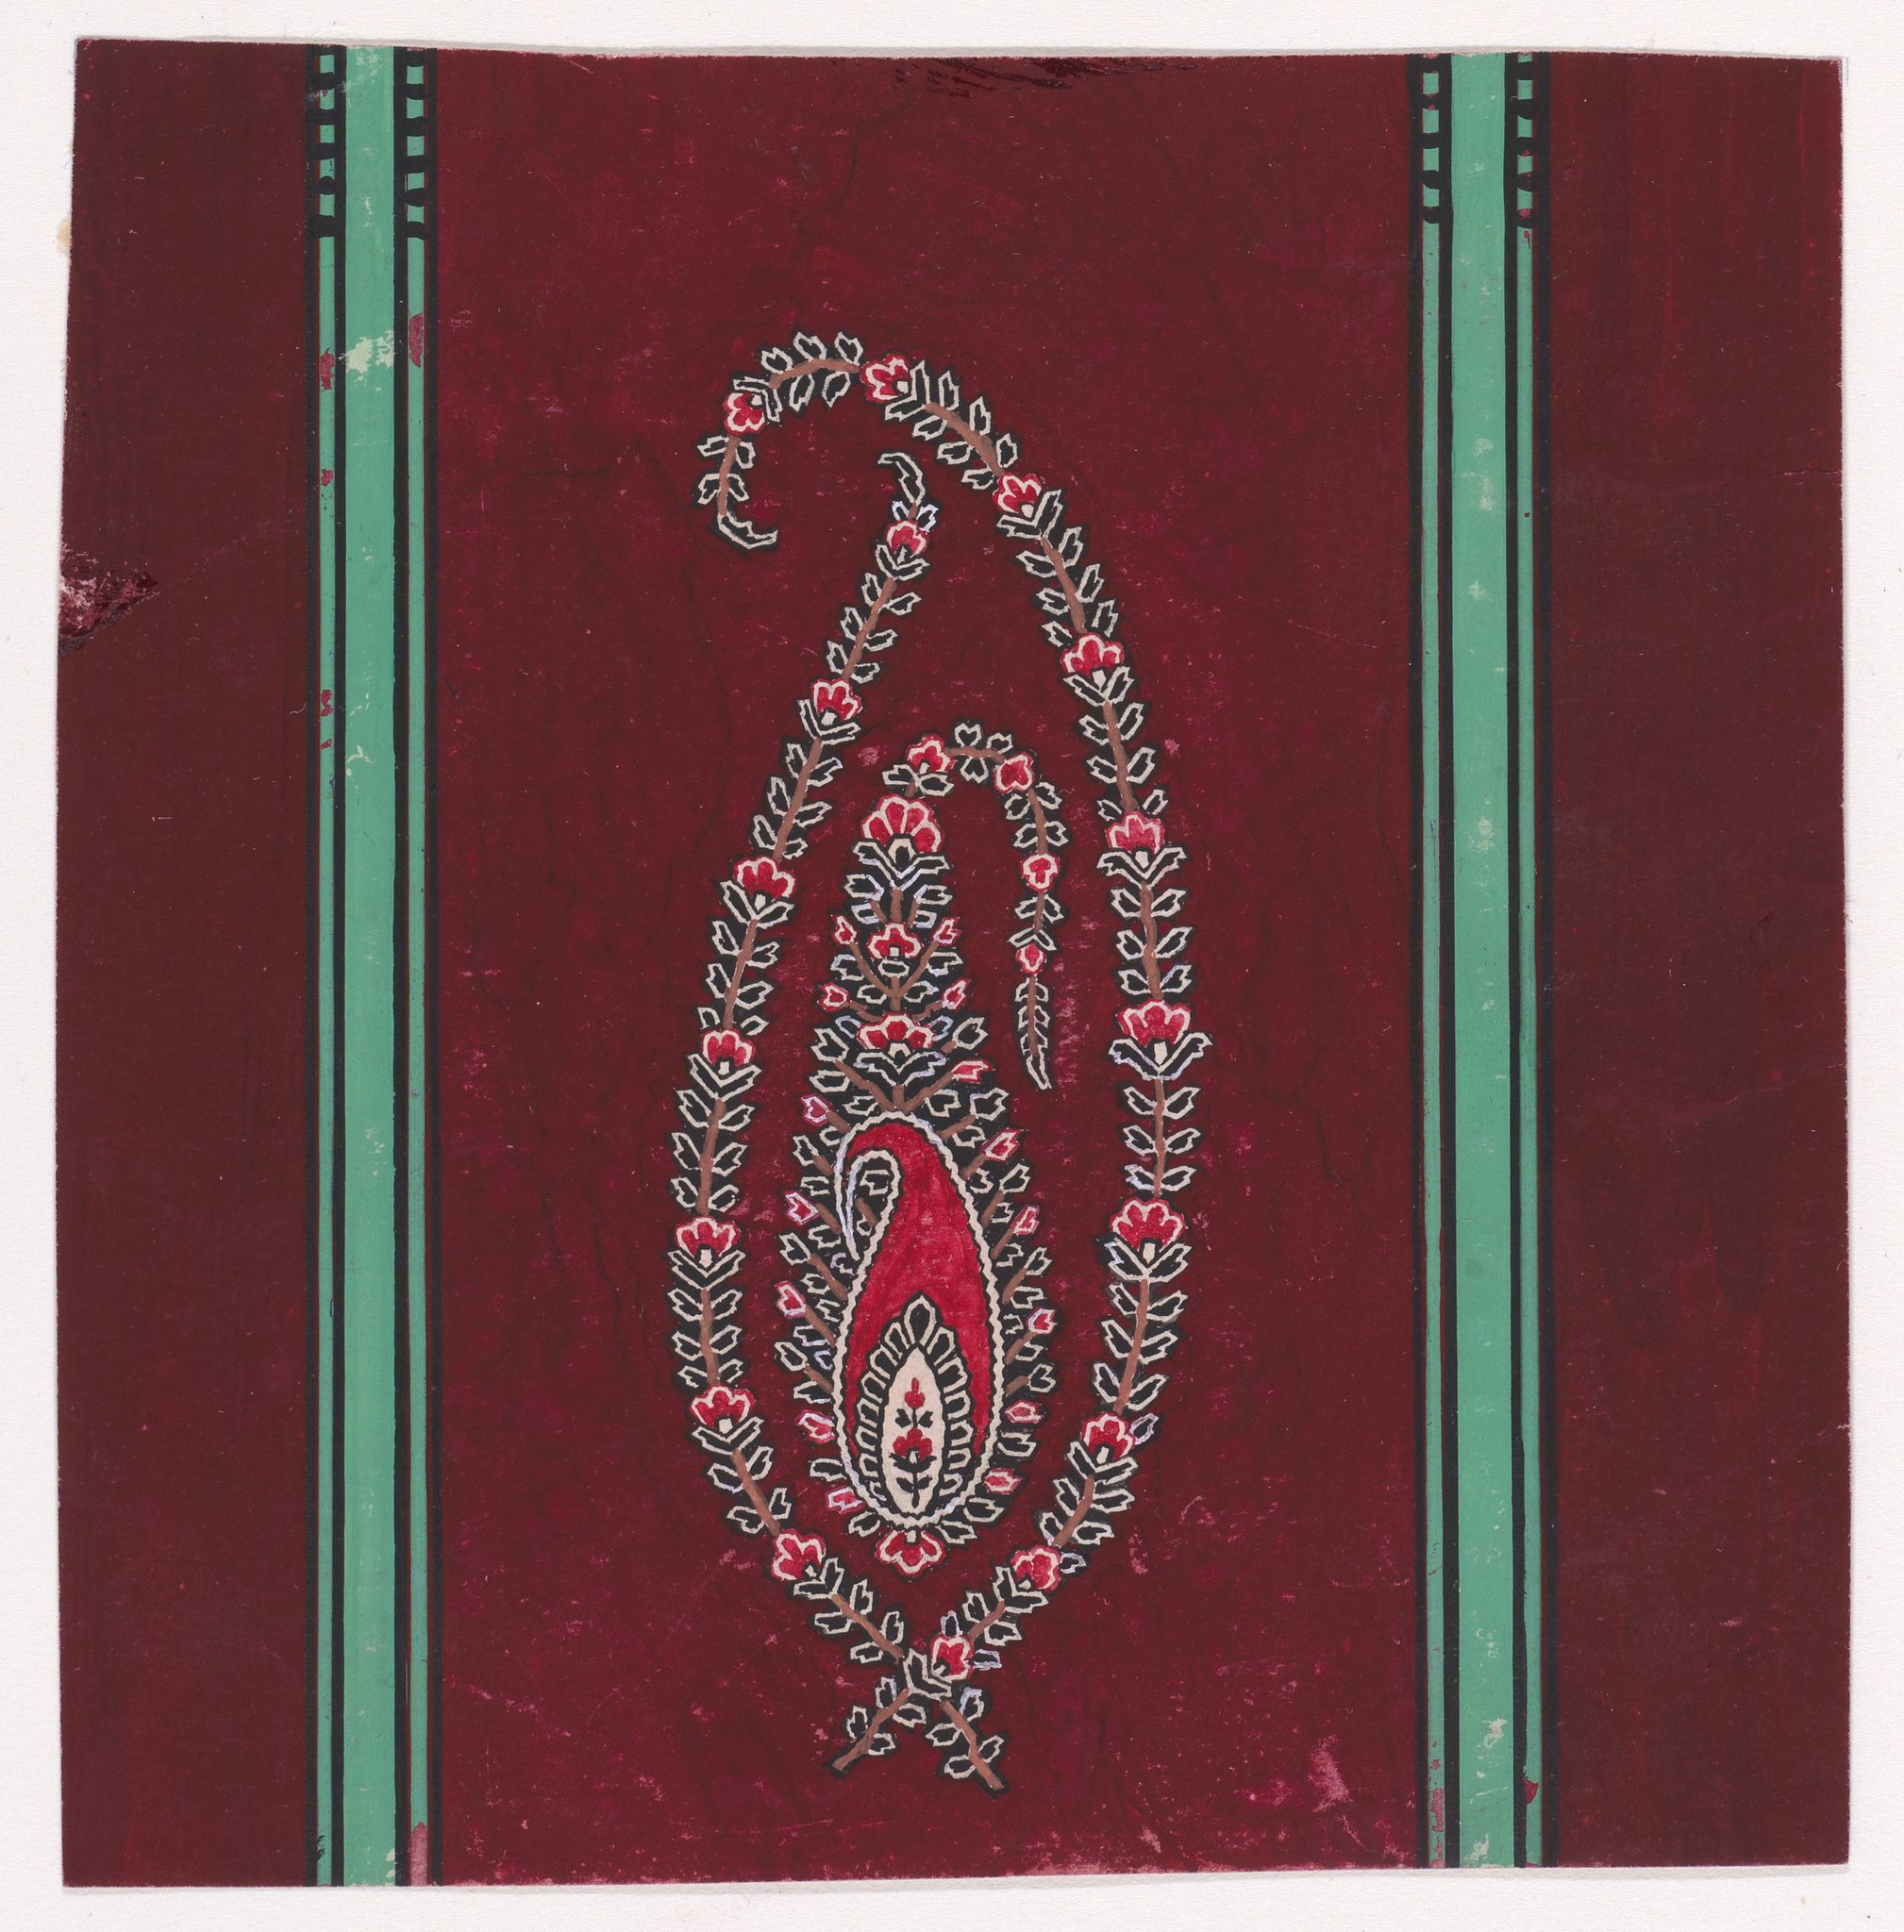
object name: drawing ornament architecture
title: Textile Design with a Paisley Motif Decorated with Branches with Small Stylized Flowers and Leaves Framed by Two Vertical Stripes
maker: anonymous, alsatian, 19th century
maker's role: artist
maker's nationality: alsatian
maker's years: 1800-1900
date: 1840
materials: gouache